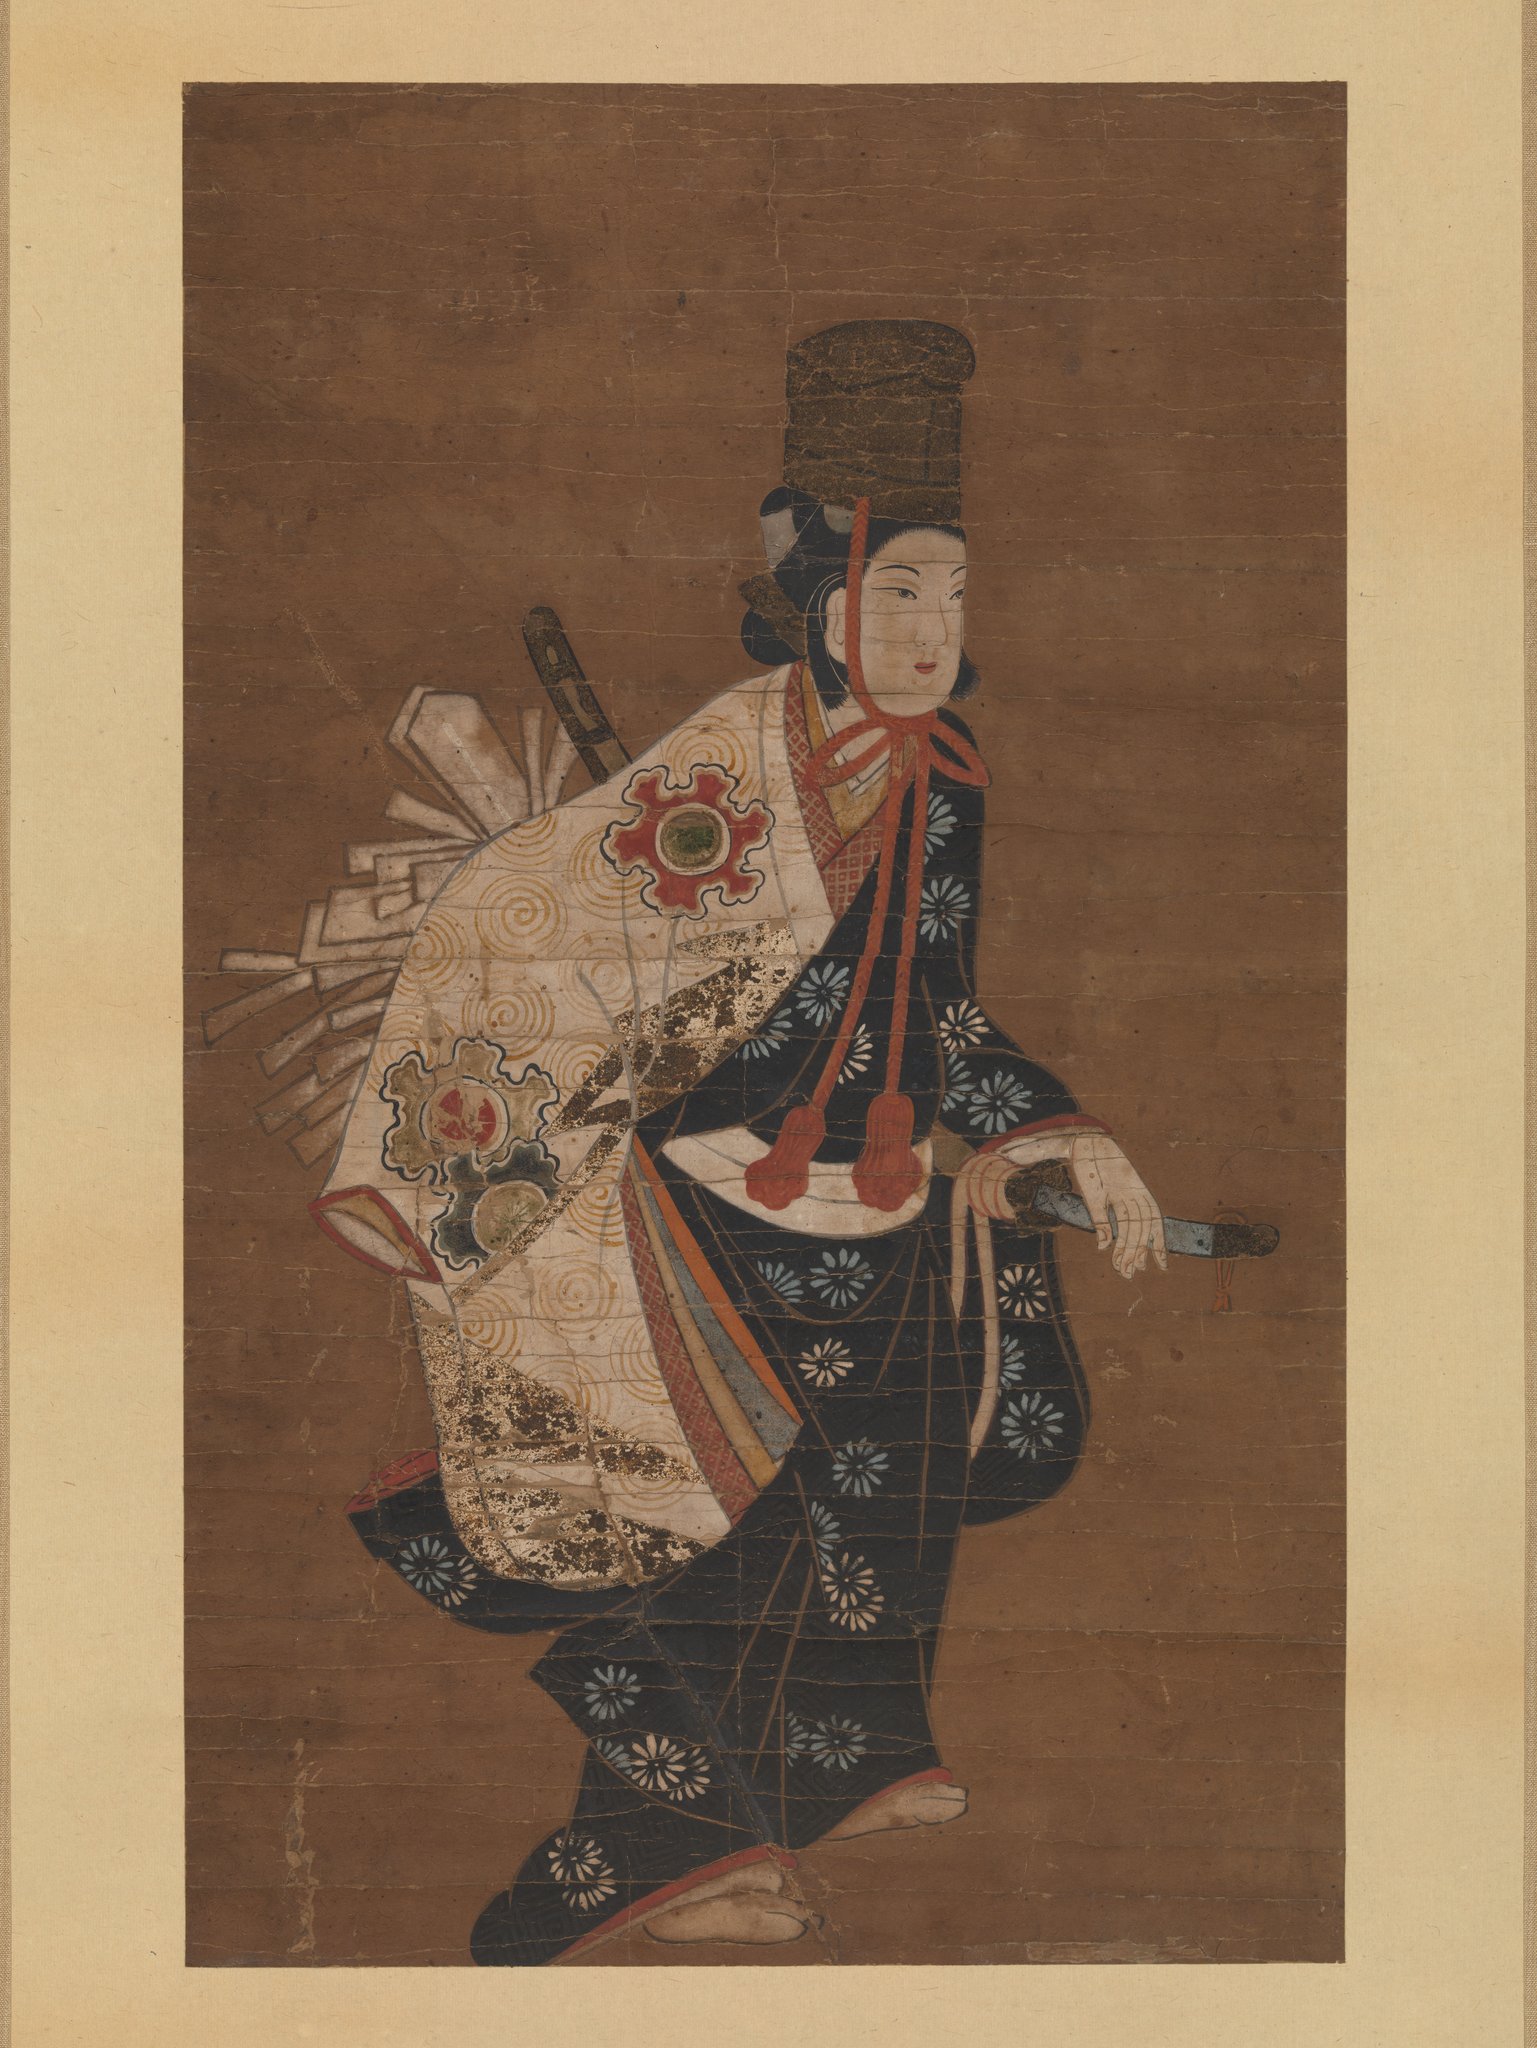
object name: hanging scroll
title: Dancer with a Sword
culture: japanese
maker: unidentified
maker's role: artist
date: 1670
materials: ink, paper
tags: swords,dancers